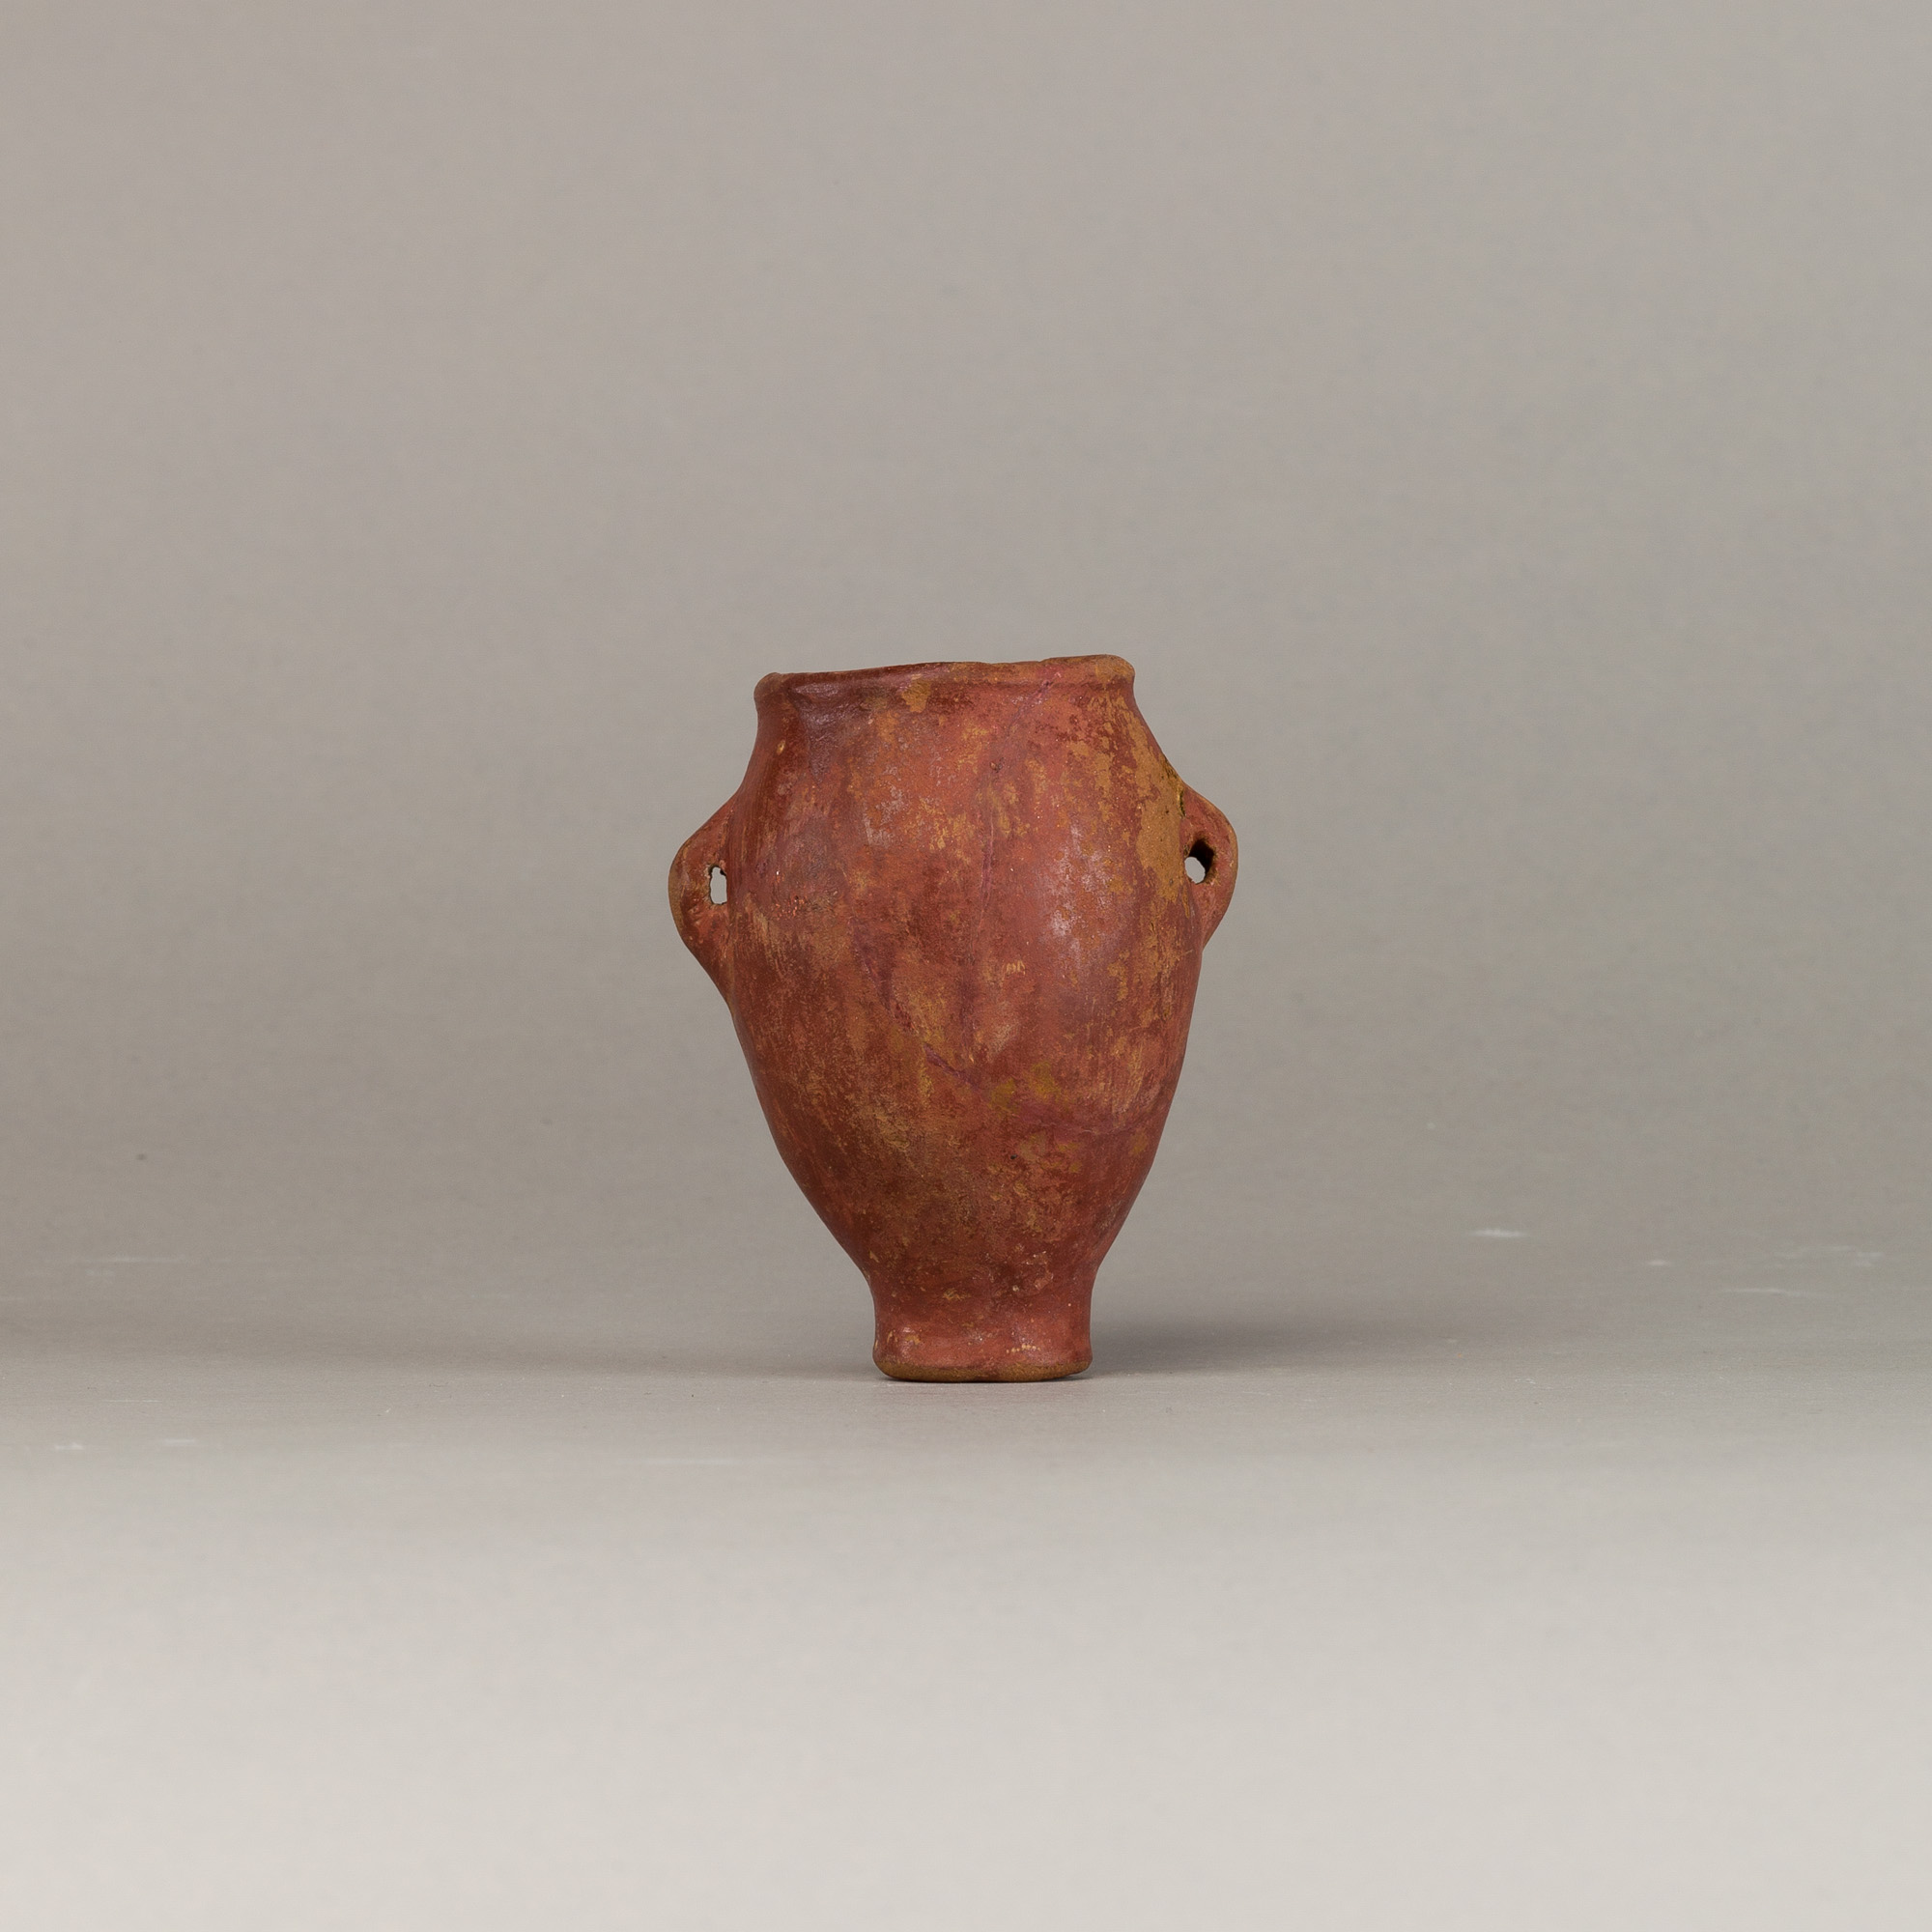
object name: jar, red polished ware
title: Polished red ware jar with lugs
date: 4500-4000 BCE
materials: pottery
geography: egypt